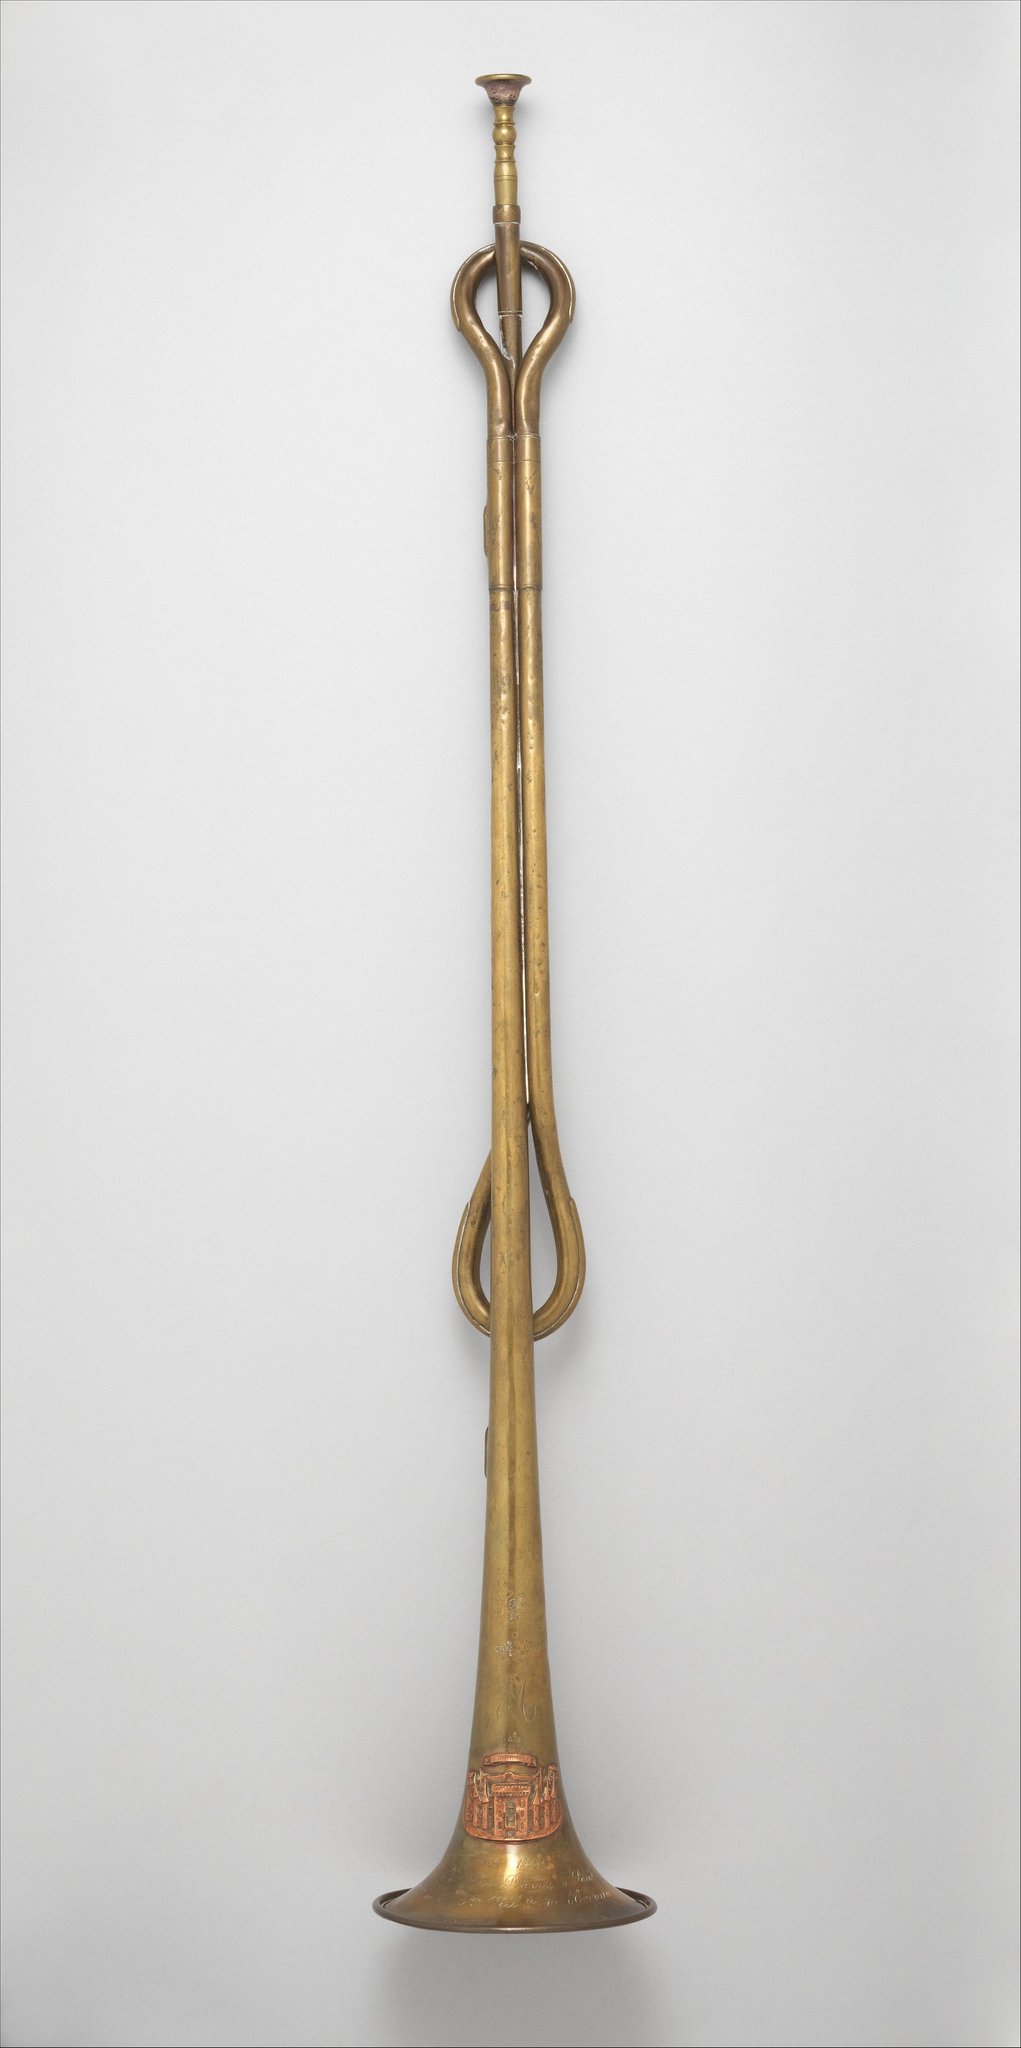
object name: fanfare trumpet in e flat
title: Fanfare trumpet in E-flat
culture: french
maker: adolphe (antoine joseph) sax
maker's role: maker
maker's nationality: belgian, active france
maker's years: 1814-1894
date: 1856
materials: brass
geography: france